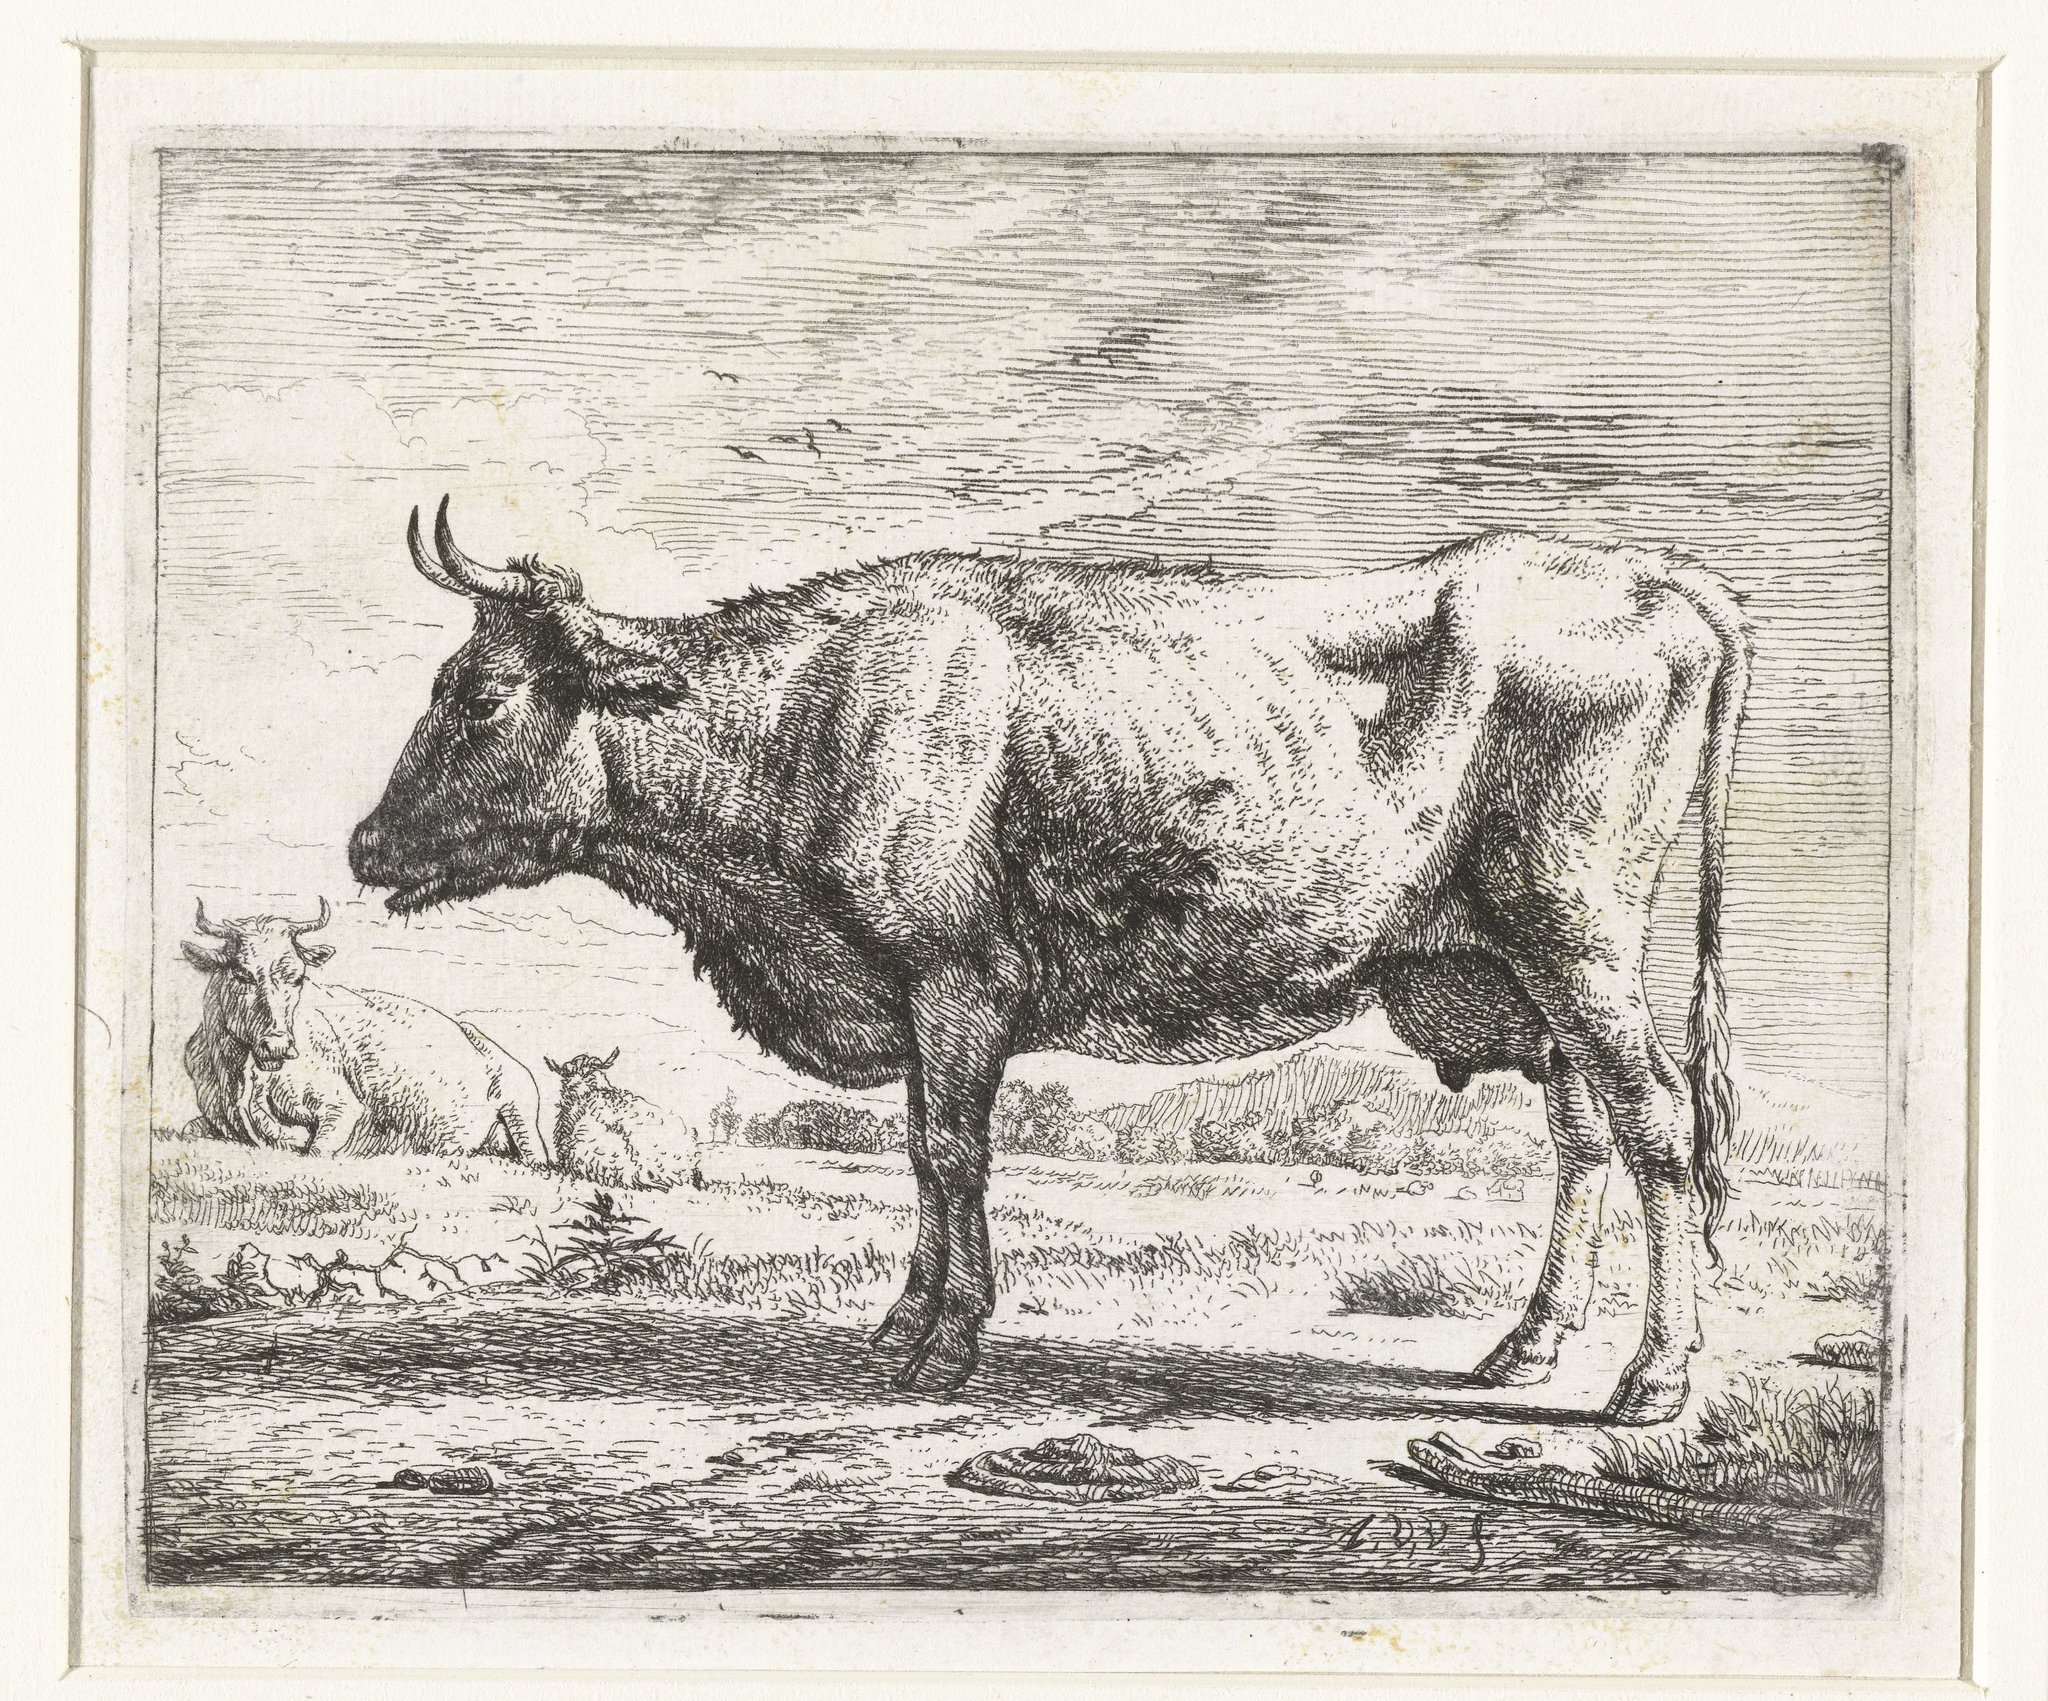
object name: print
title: Verschillende dieren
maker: adriaen van de velde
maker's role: draughtsman, painter, print maker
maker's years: 1636-1672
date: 1657-1659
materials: paper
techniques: etching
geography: amsterdam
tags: cow, sheep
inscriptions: collector's mark: Lugt 240